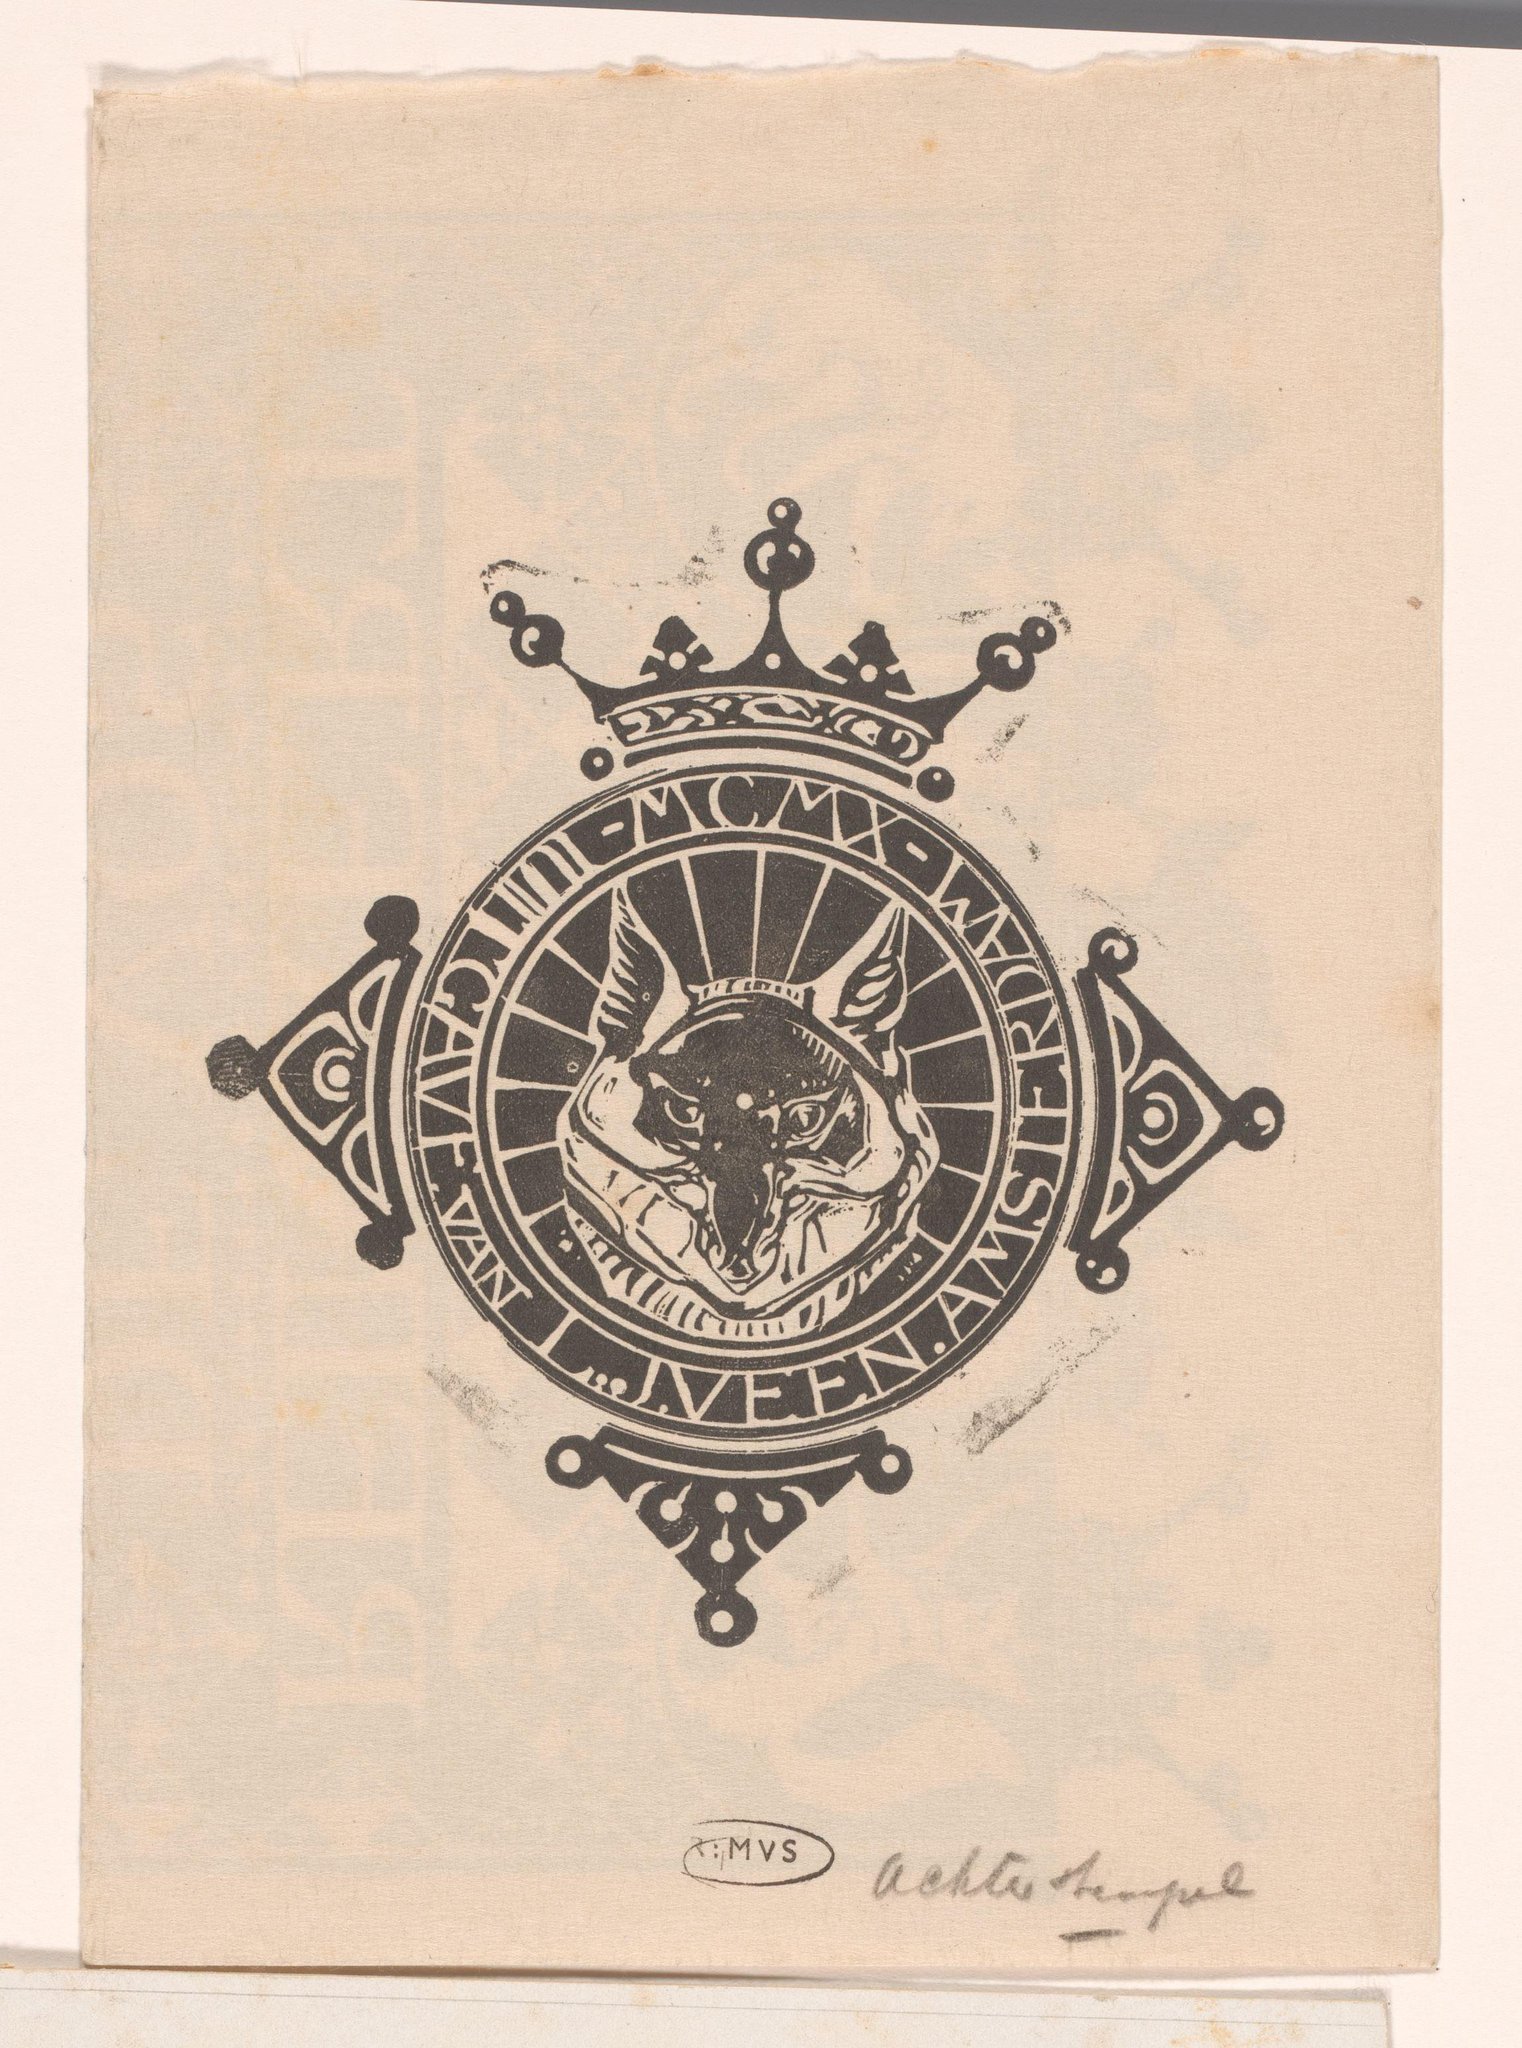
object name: boekillustratie ontwerp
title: Vignet voor uitgever L.J. Veen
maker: bernard willem wierink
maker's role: draughtsman, print maker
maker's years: 1856-1939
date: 1910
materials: paper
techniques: relief print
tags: device (trade-mark of printer or publisher), fable of reynard the fox, beasts of prey, predatory animals: fox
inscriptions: collector's mark: Lugt 2228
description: Ontwerp voor: Streuvels, Stijn (Frank Lateur). Reinaert de Vos naar verschillende uitgaven van het middeleeuwsche epos. Amsterdam: L.J. Veen, 1910. Deze prent is vermoedelijk een plaatsnede, ook al wordt in de literatuur veelal gesproken over een houtsnede. Voor zover Wierink zijn prenten in hoogdruk zelf nader heeft omschreven, heeft hij altijd de term 'plaatsnede' gebruikt.